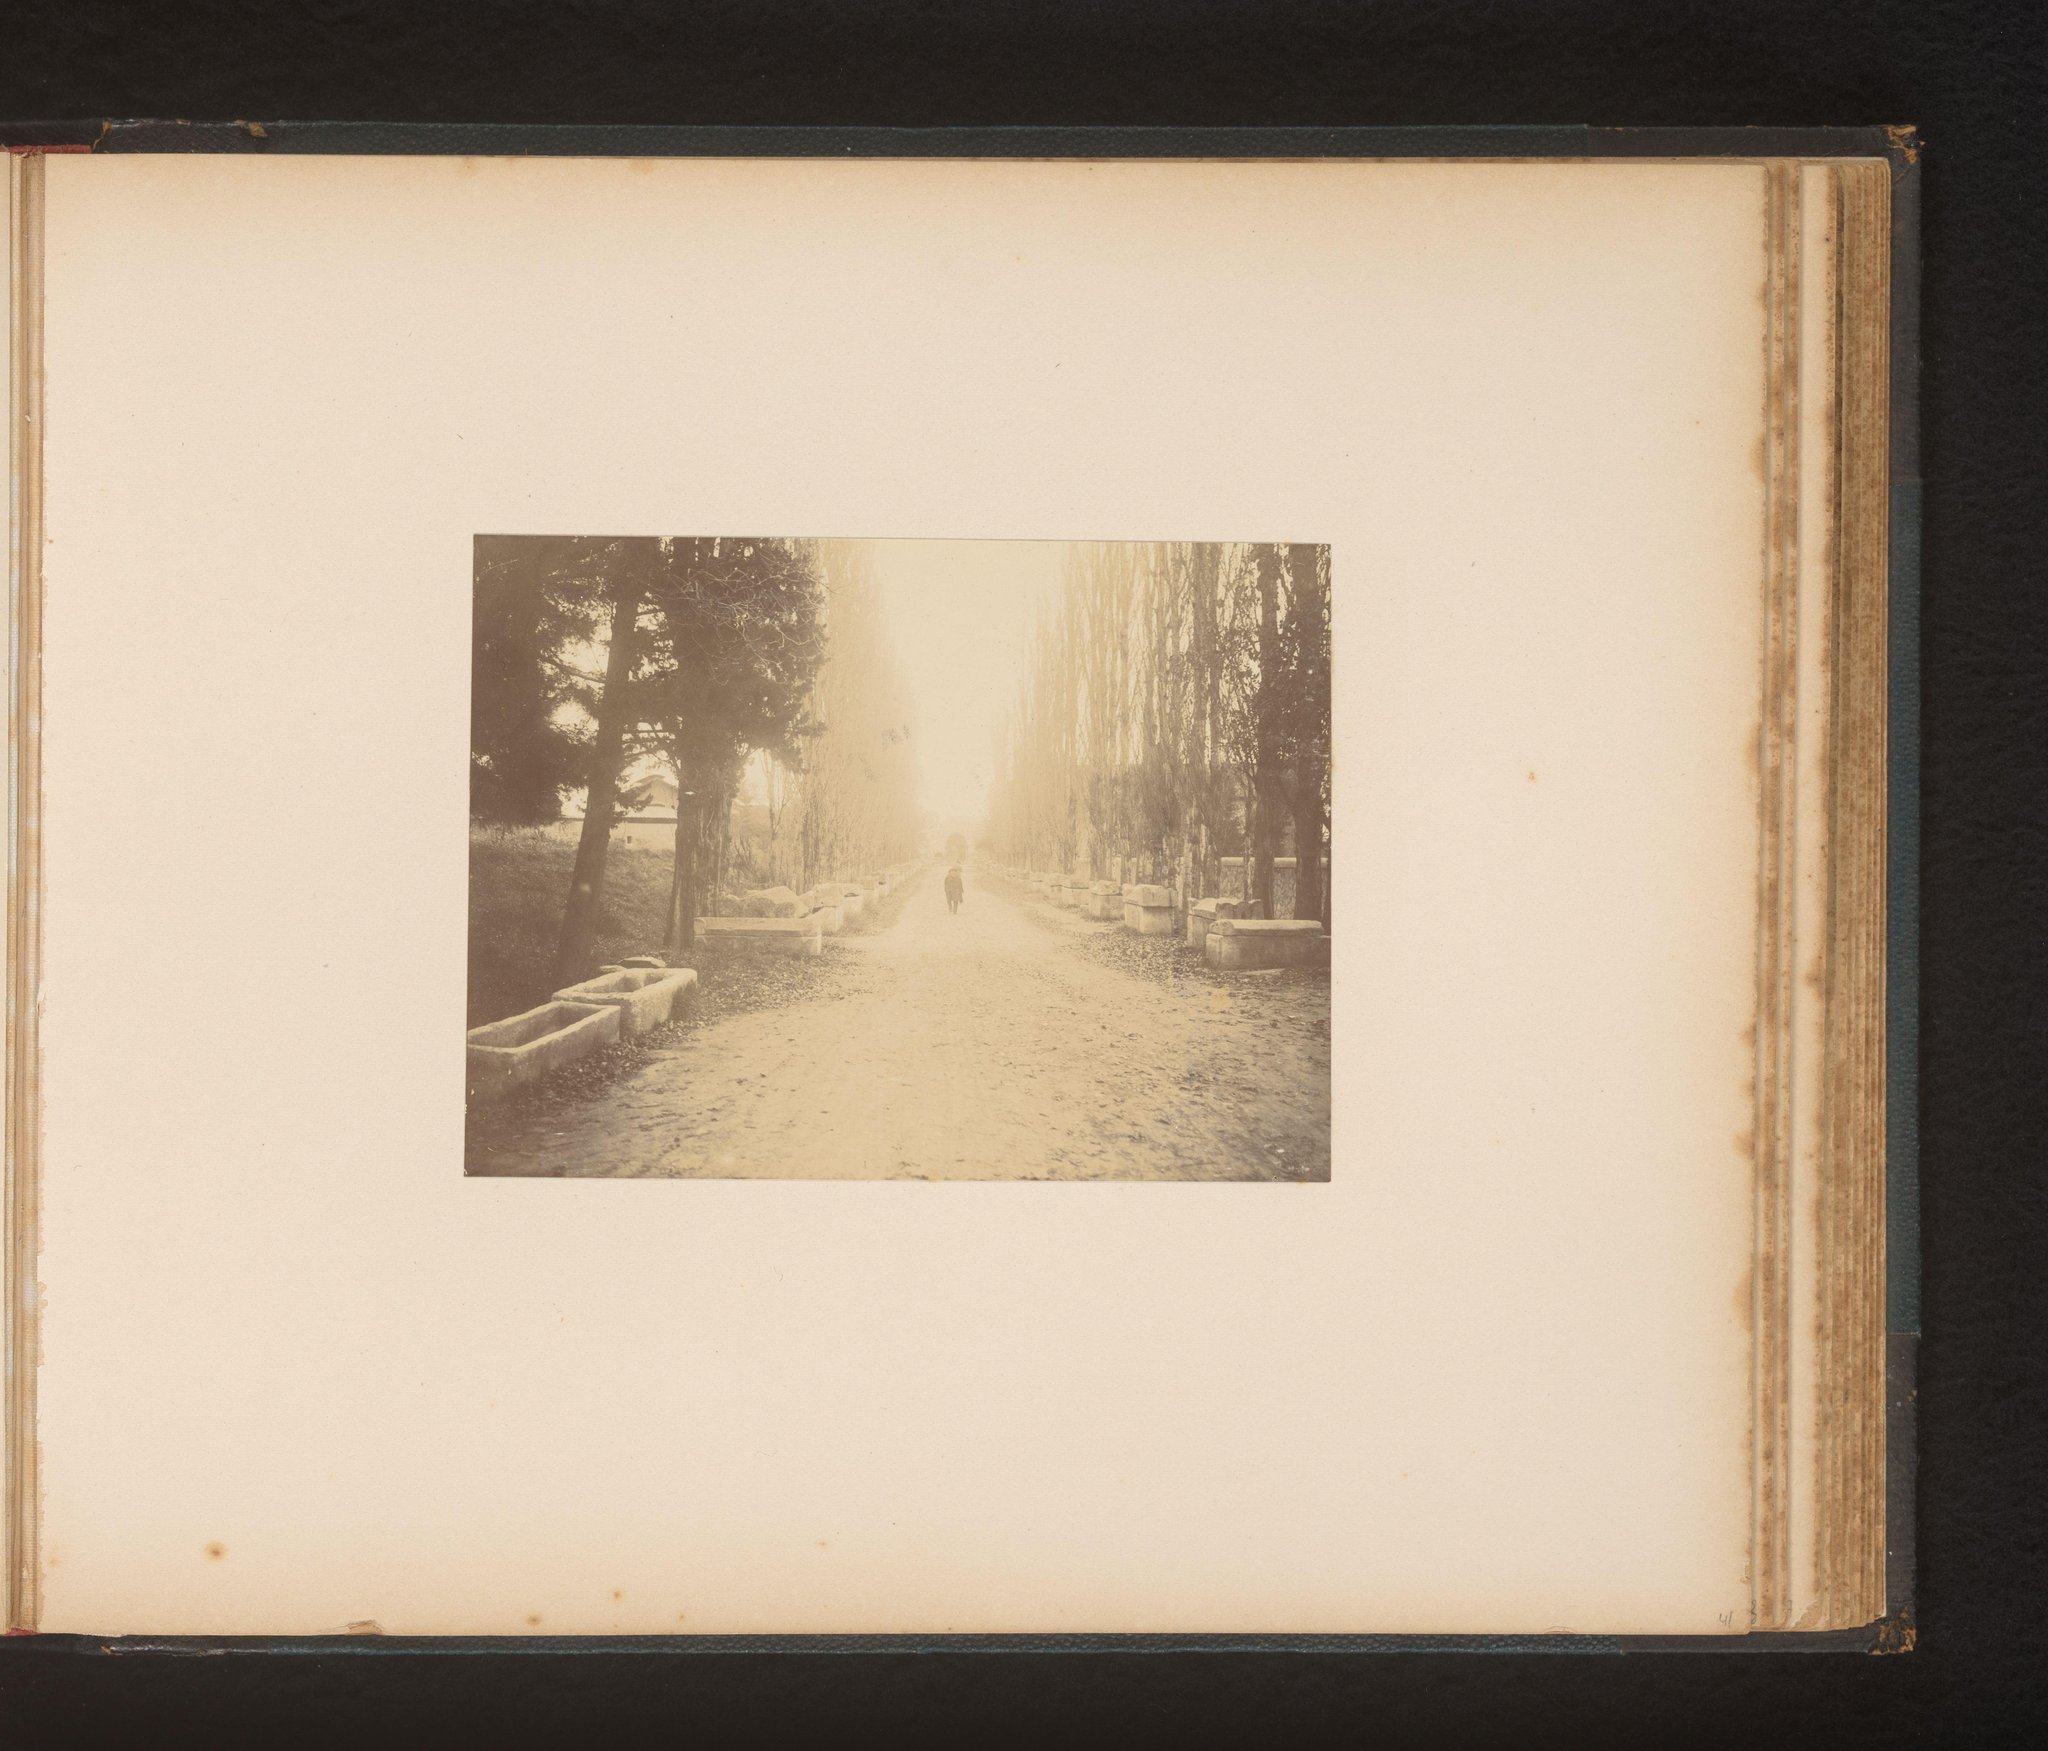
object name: album leaf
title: Alyscamps te Arles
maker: Anonymous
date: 1880-1920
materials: cardboard, photographic support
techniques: gelatin silver print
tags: trees, necropolis, historical persons